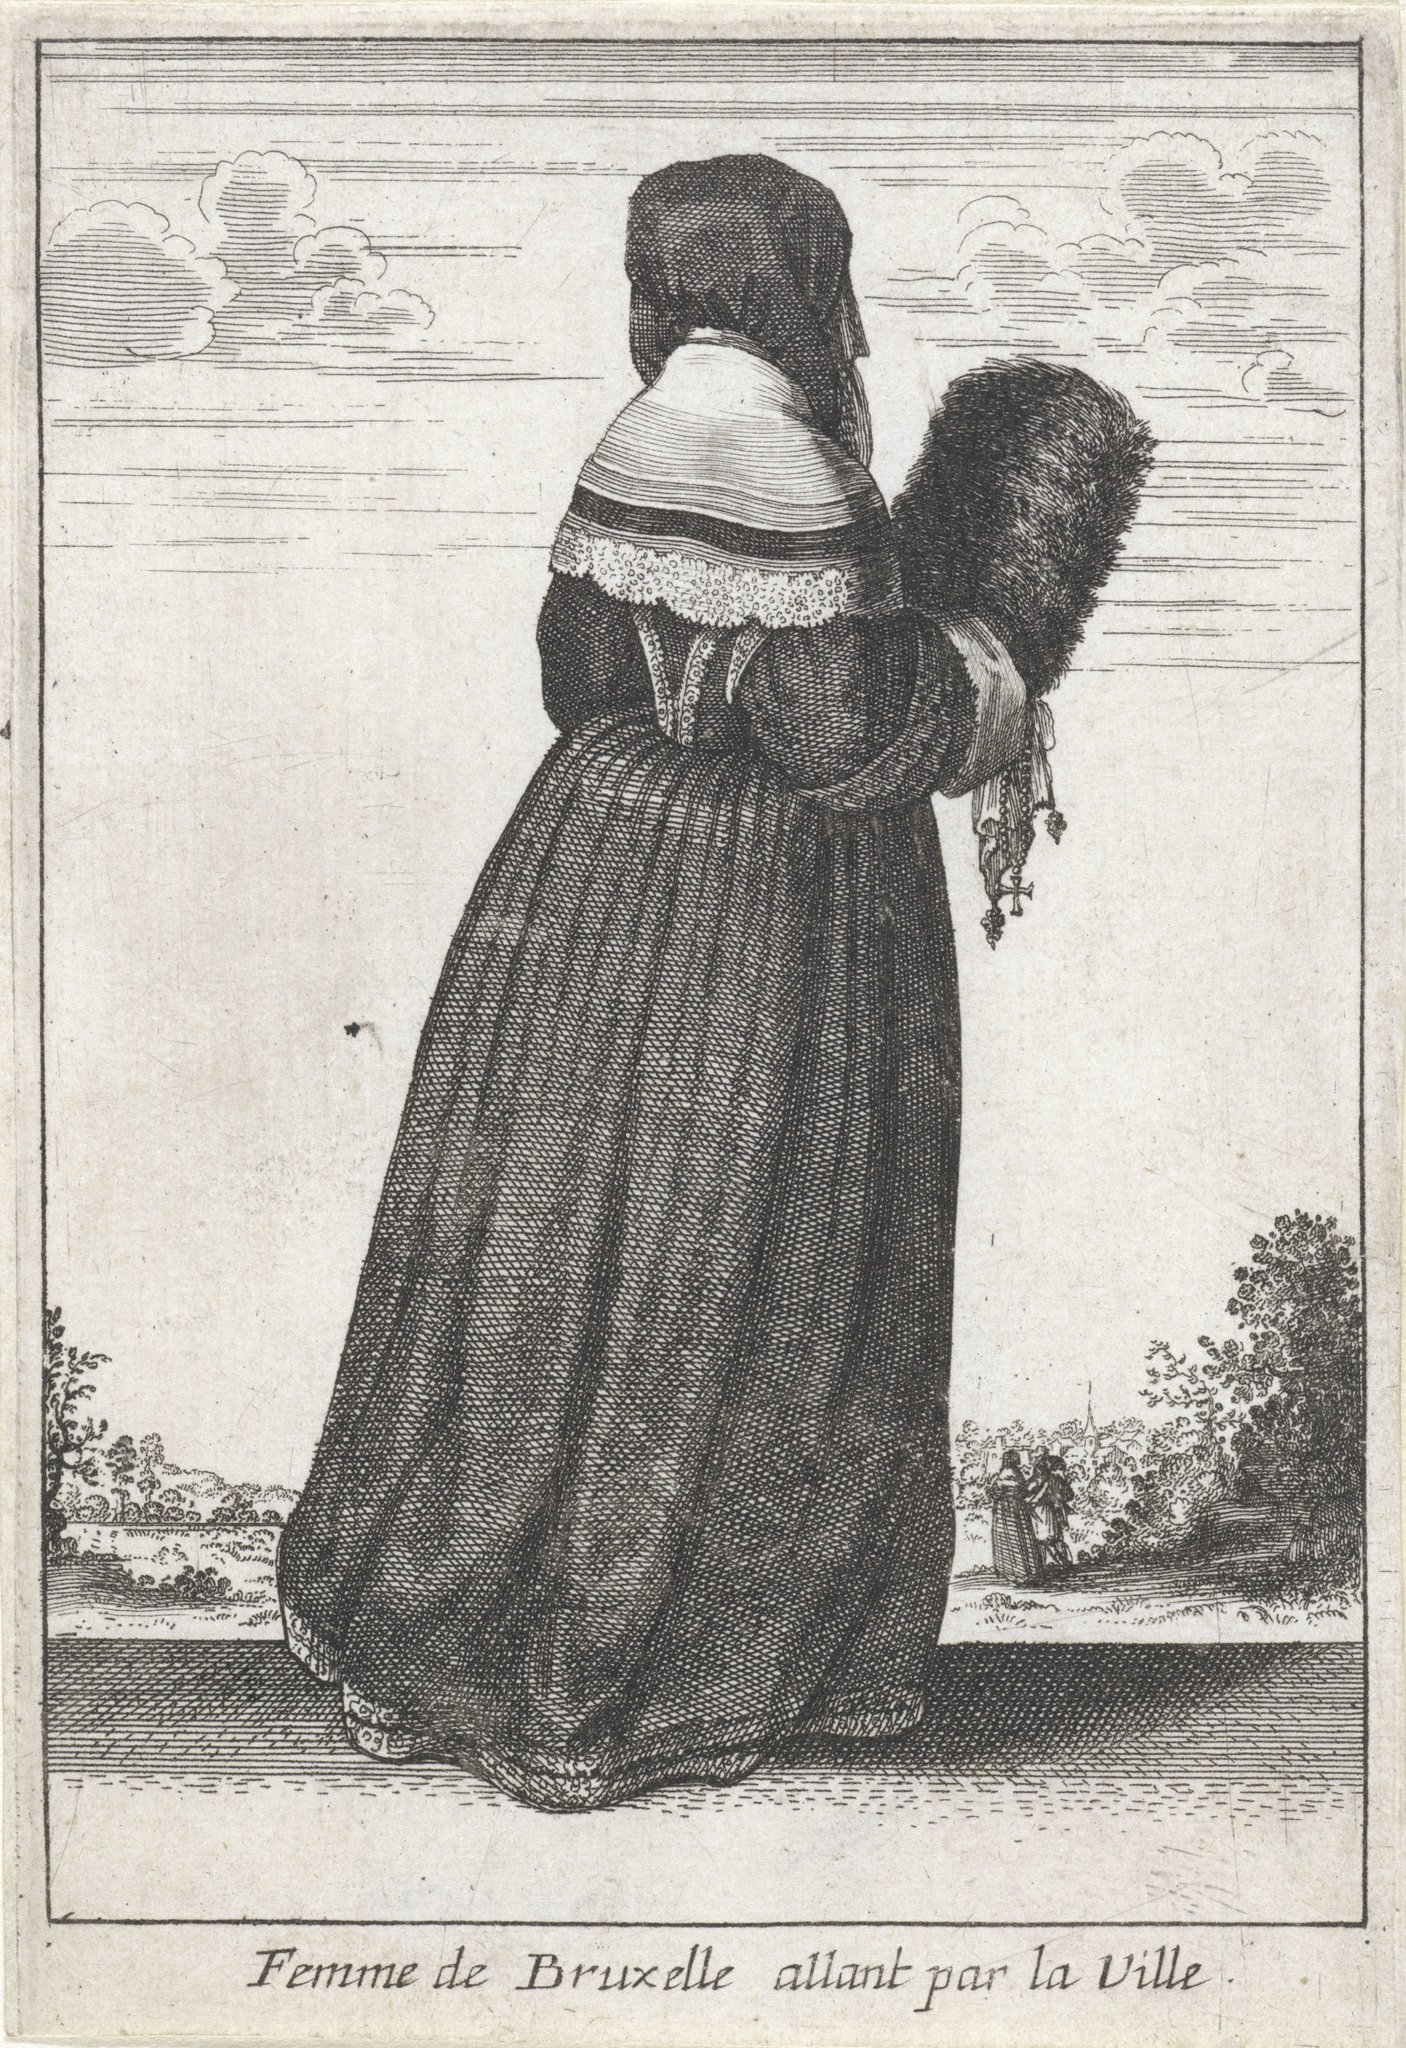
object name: costume print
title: Brusselse dame, naar de stad lopend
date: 1662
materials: paper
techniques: etching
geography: paris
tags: brussels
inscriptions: collector's mark: Lugt 240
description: Vrouw uit Brussel, schuin op de rug gezien, naar rechts gekeerd. Een donkere, soepelvallende hoofddoek over het haar met een sluier voor het gezicht. Dubbele halsdoek, afgezet met stroken kant. Japon met wijde mouwen en geplooide rok over een beuling. De coupenaden van het lijf, op de rug versierd met stroken kant, die ook op de onderarm terugkomen. In de rechterhand een bontmof, zakdoek en rozenkrans. Kopie naar 'Nobilis Mulier Brabantica' .